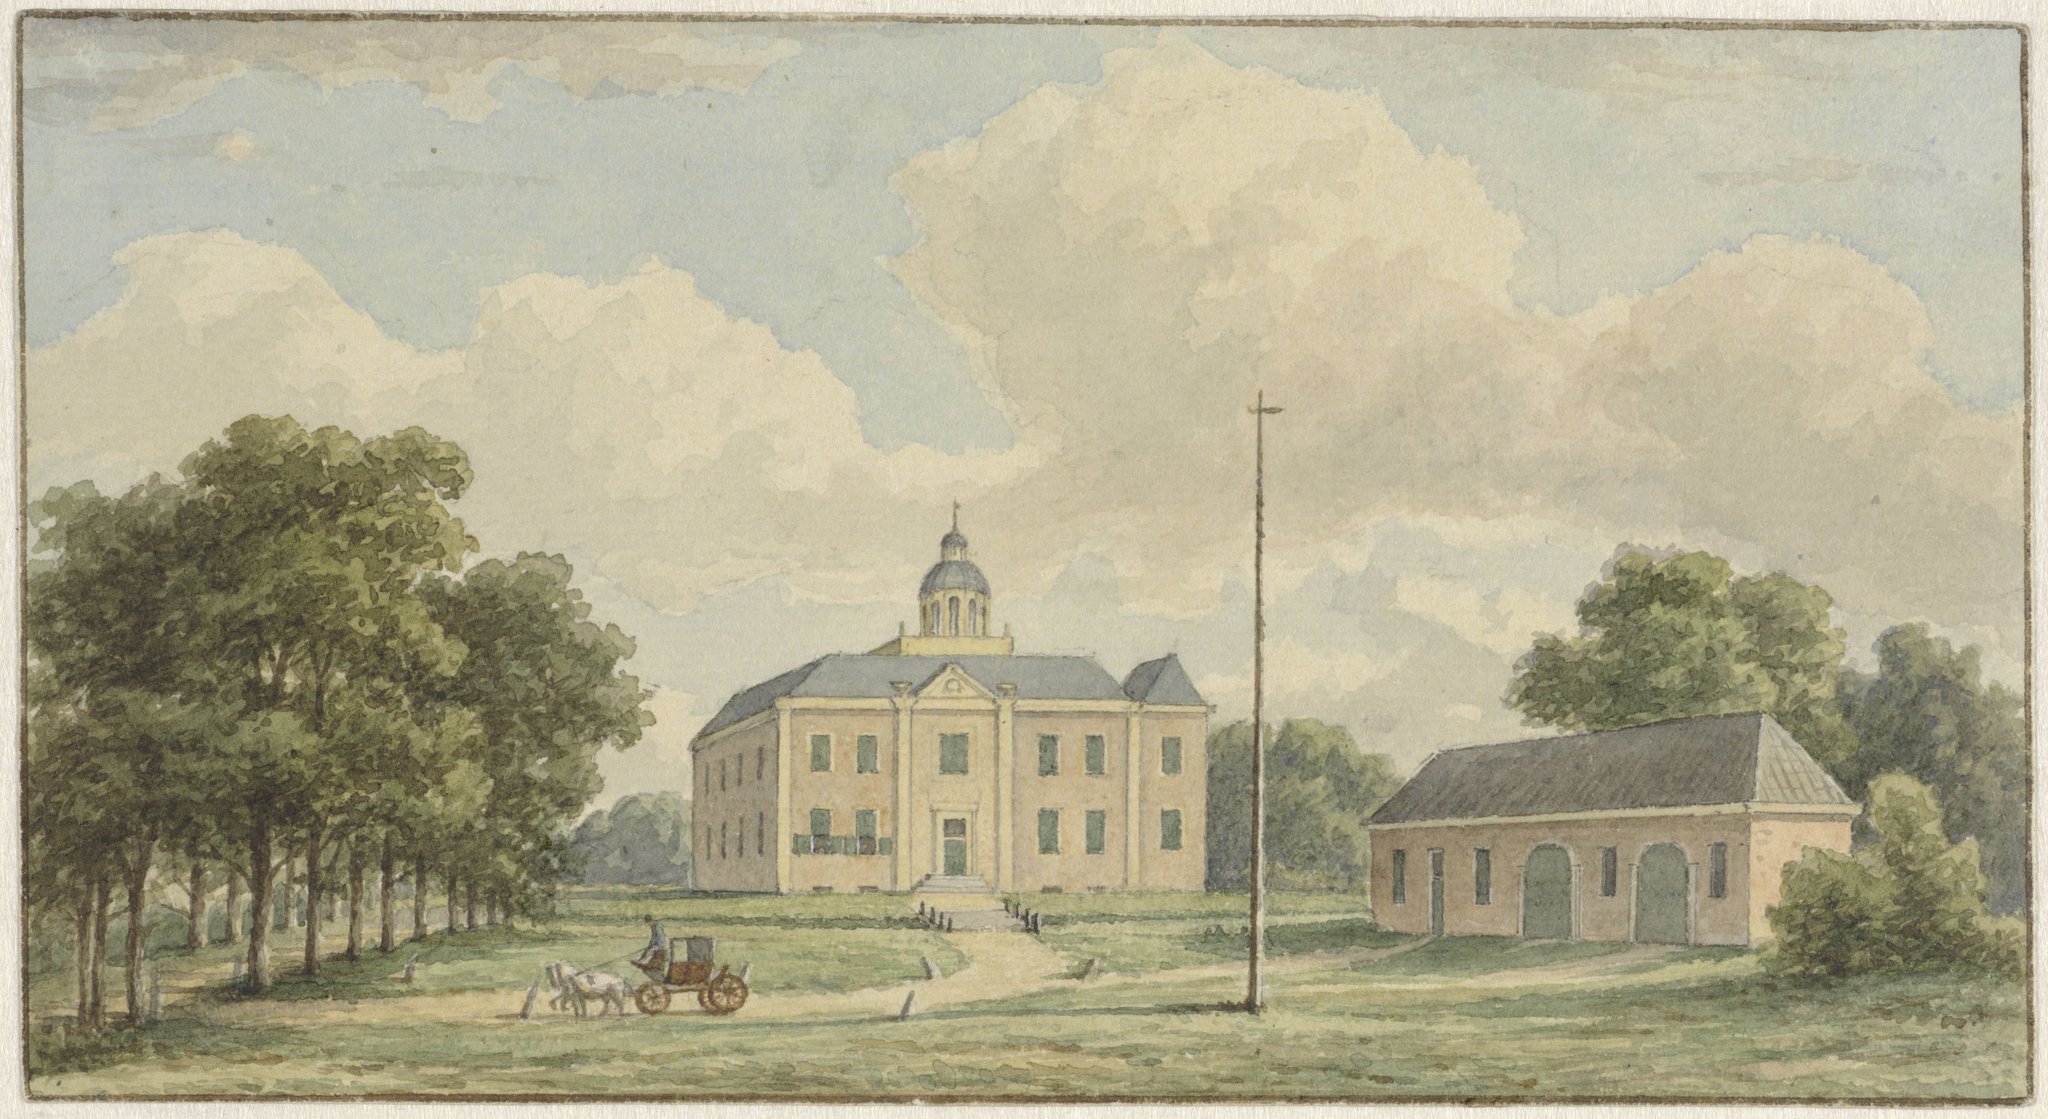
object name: watercolor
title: Huis De Cloese, bij Lochem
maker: christianus hendricus hein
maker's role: draughtsman, print maker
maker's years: 1815-1879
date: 1825-1879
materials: paper, watercolor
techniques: brush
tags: castle